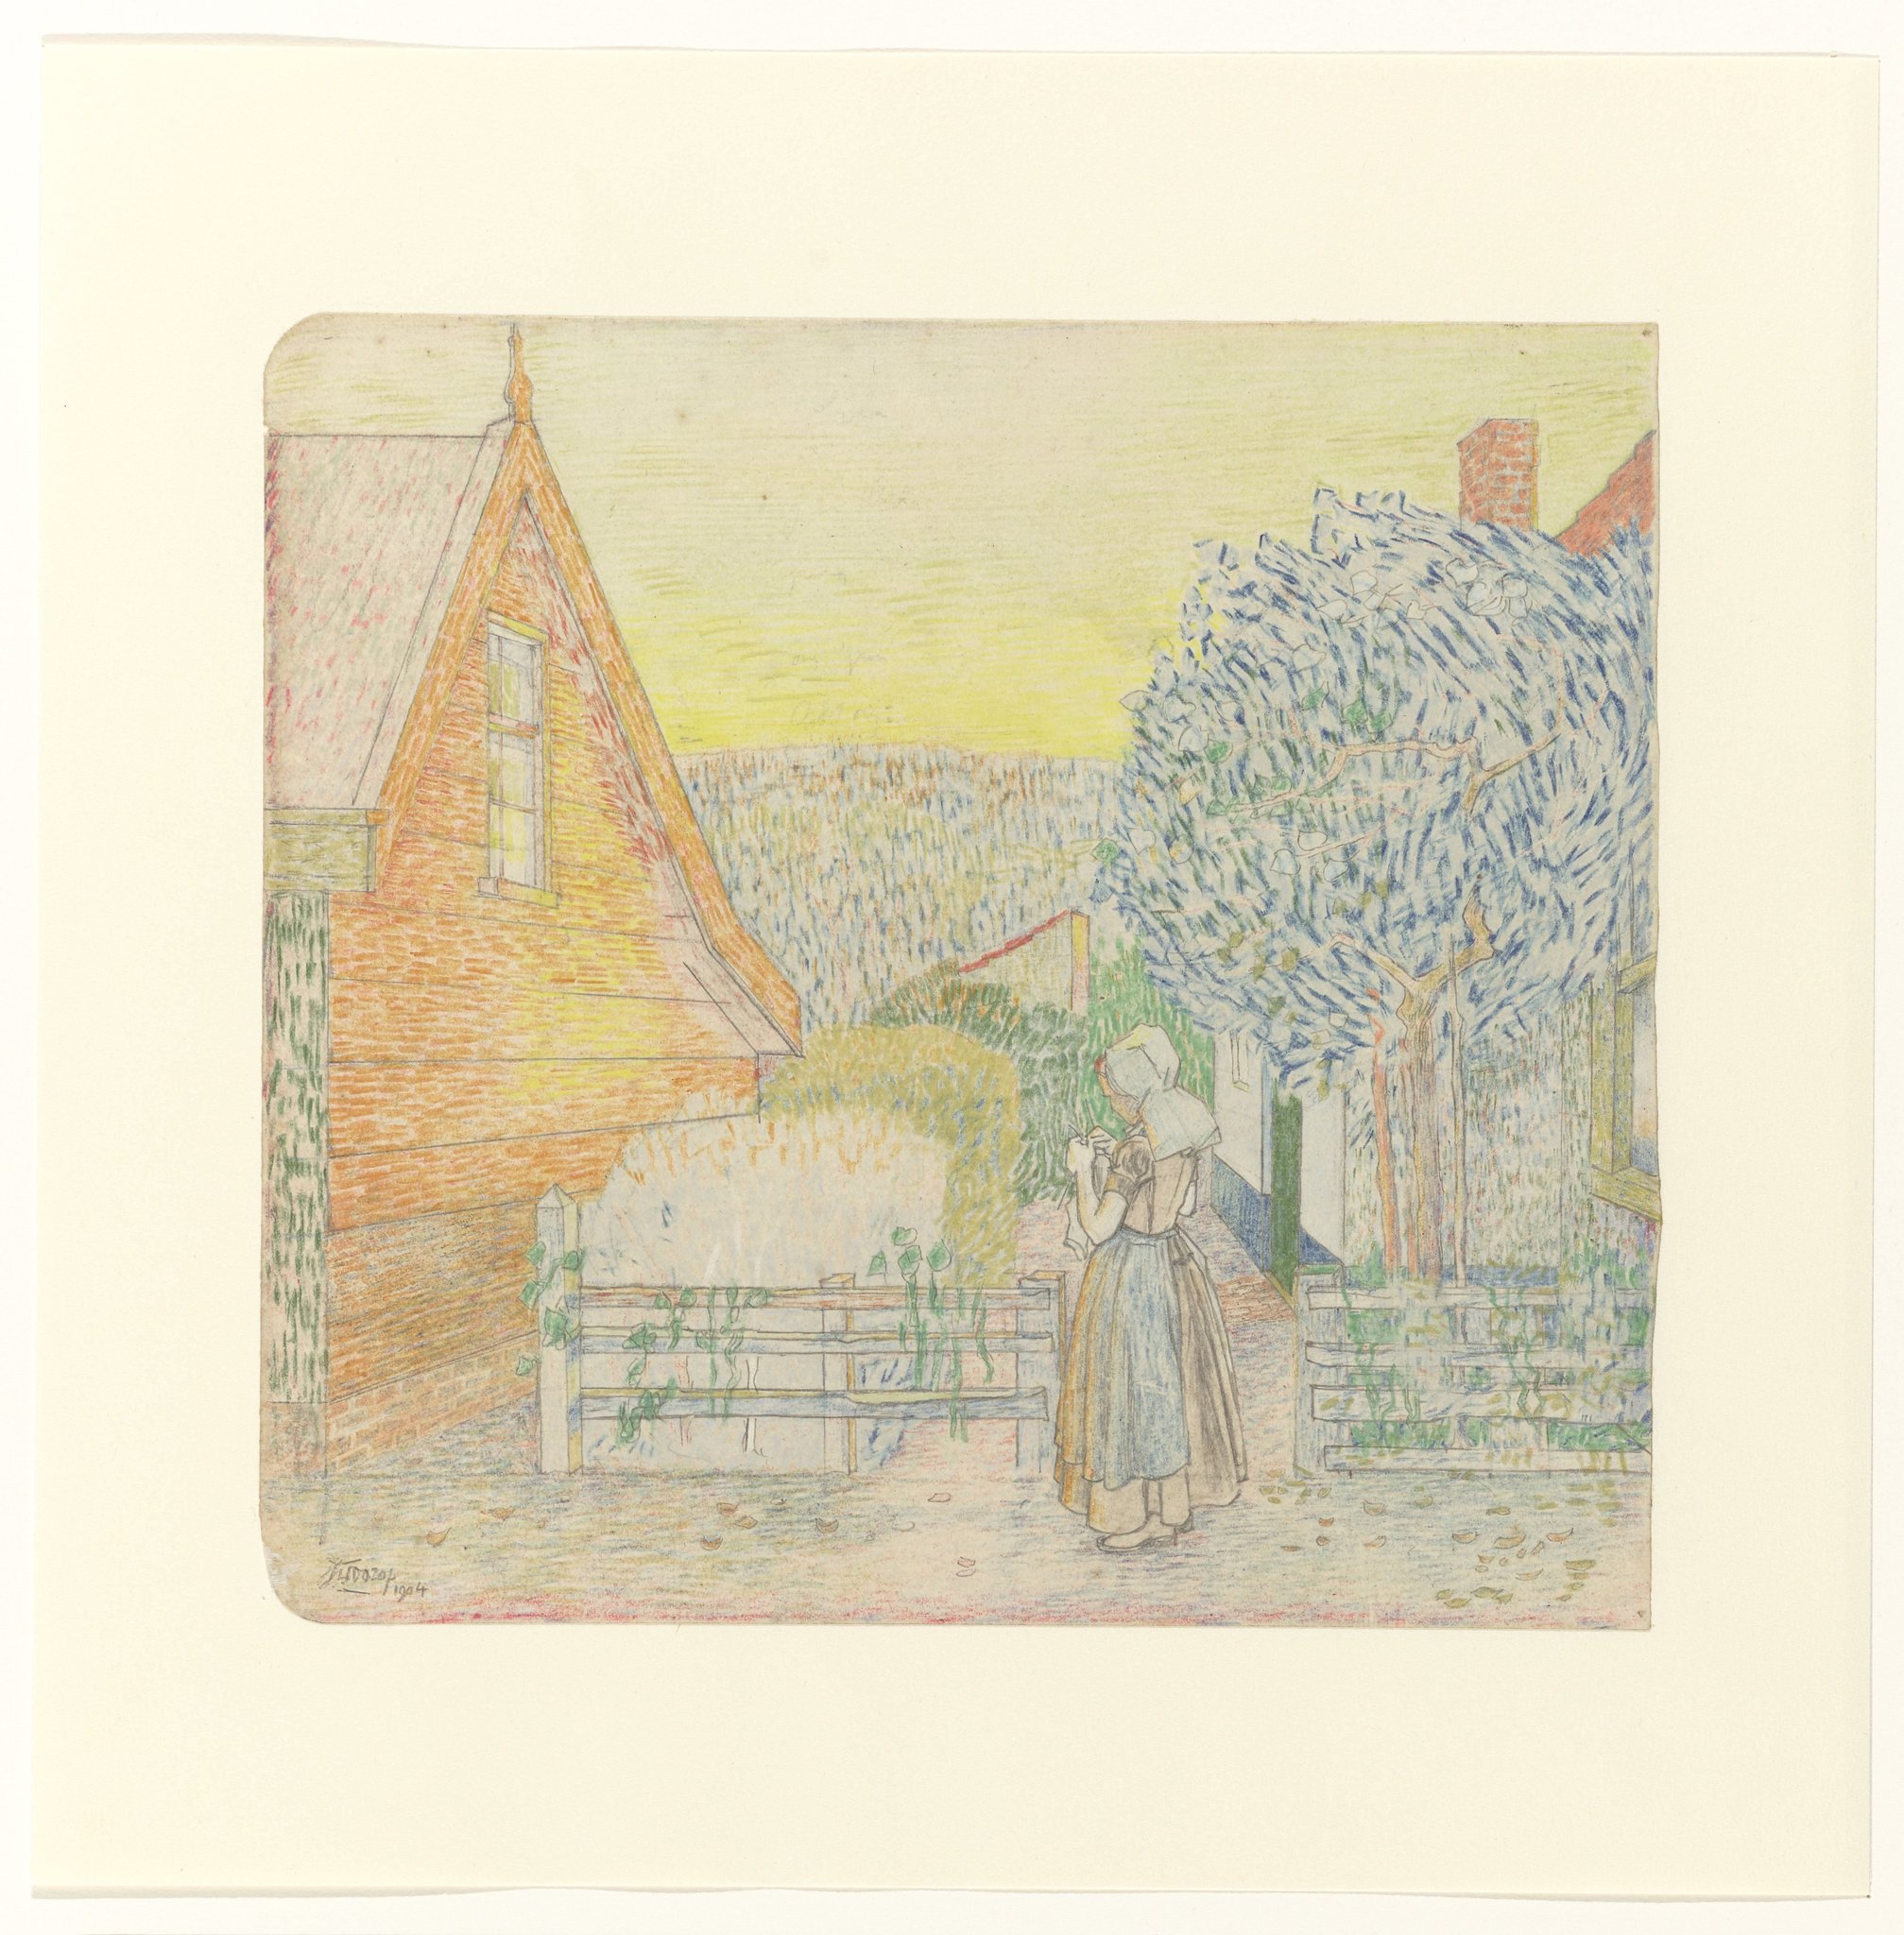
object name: drawing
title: Zeeuws meisje, breiend op een binnenplaatsje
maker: jan toorop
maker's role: draughtsman, painter, print maker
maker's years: 1858-1928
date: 1904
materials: chalk, paper, pencil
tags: village, zeeland